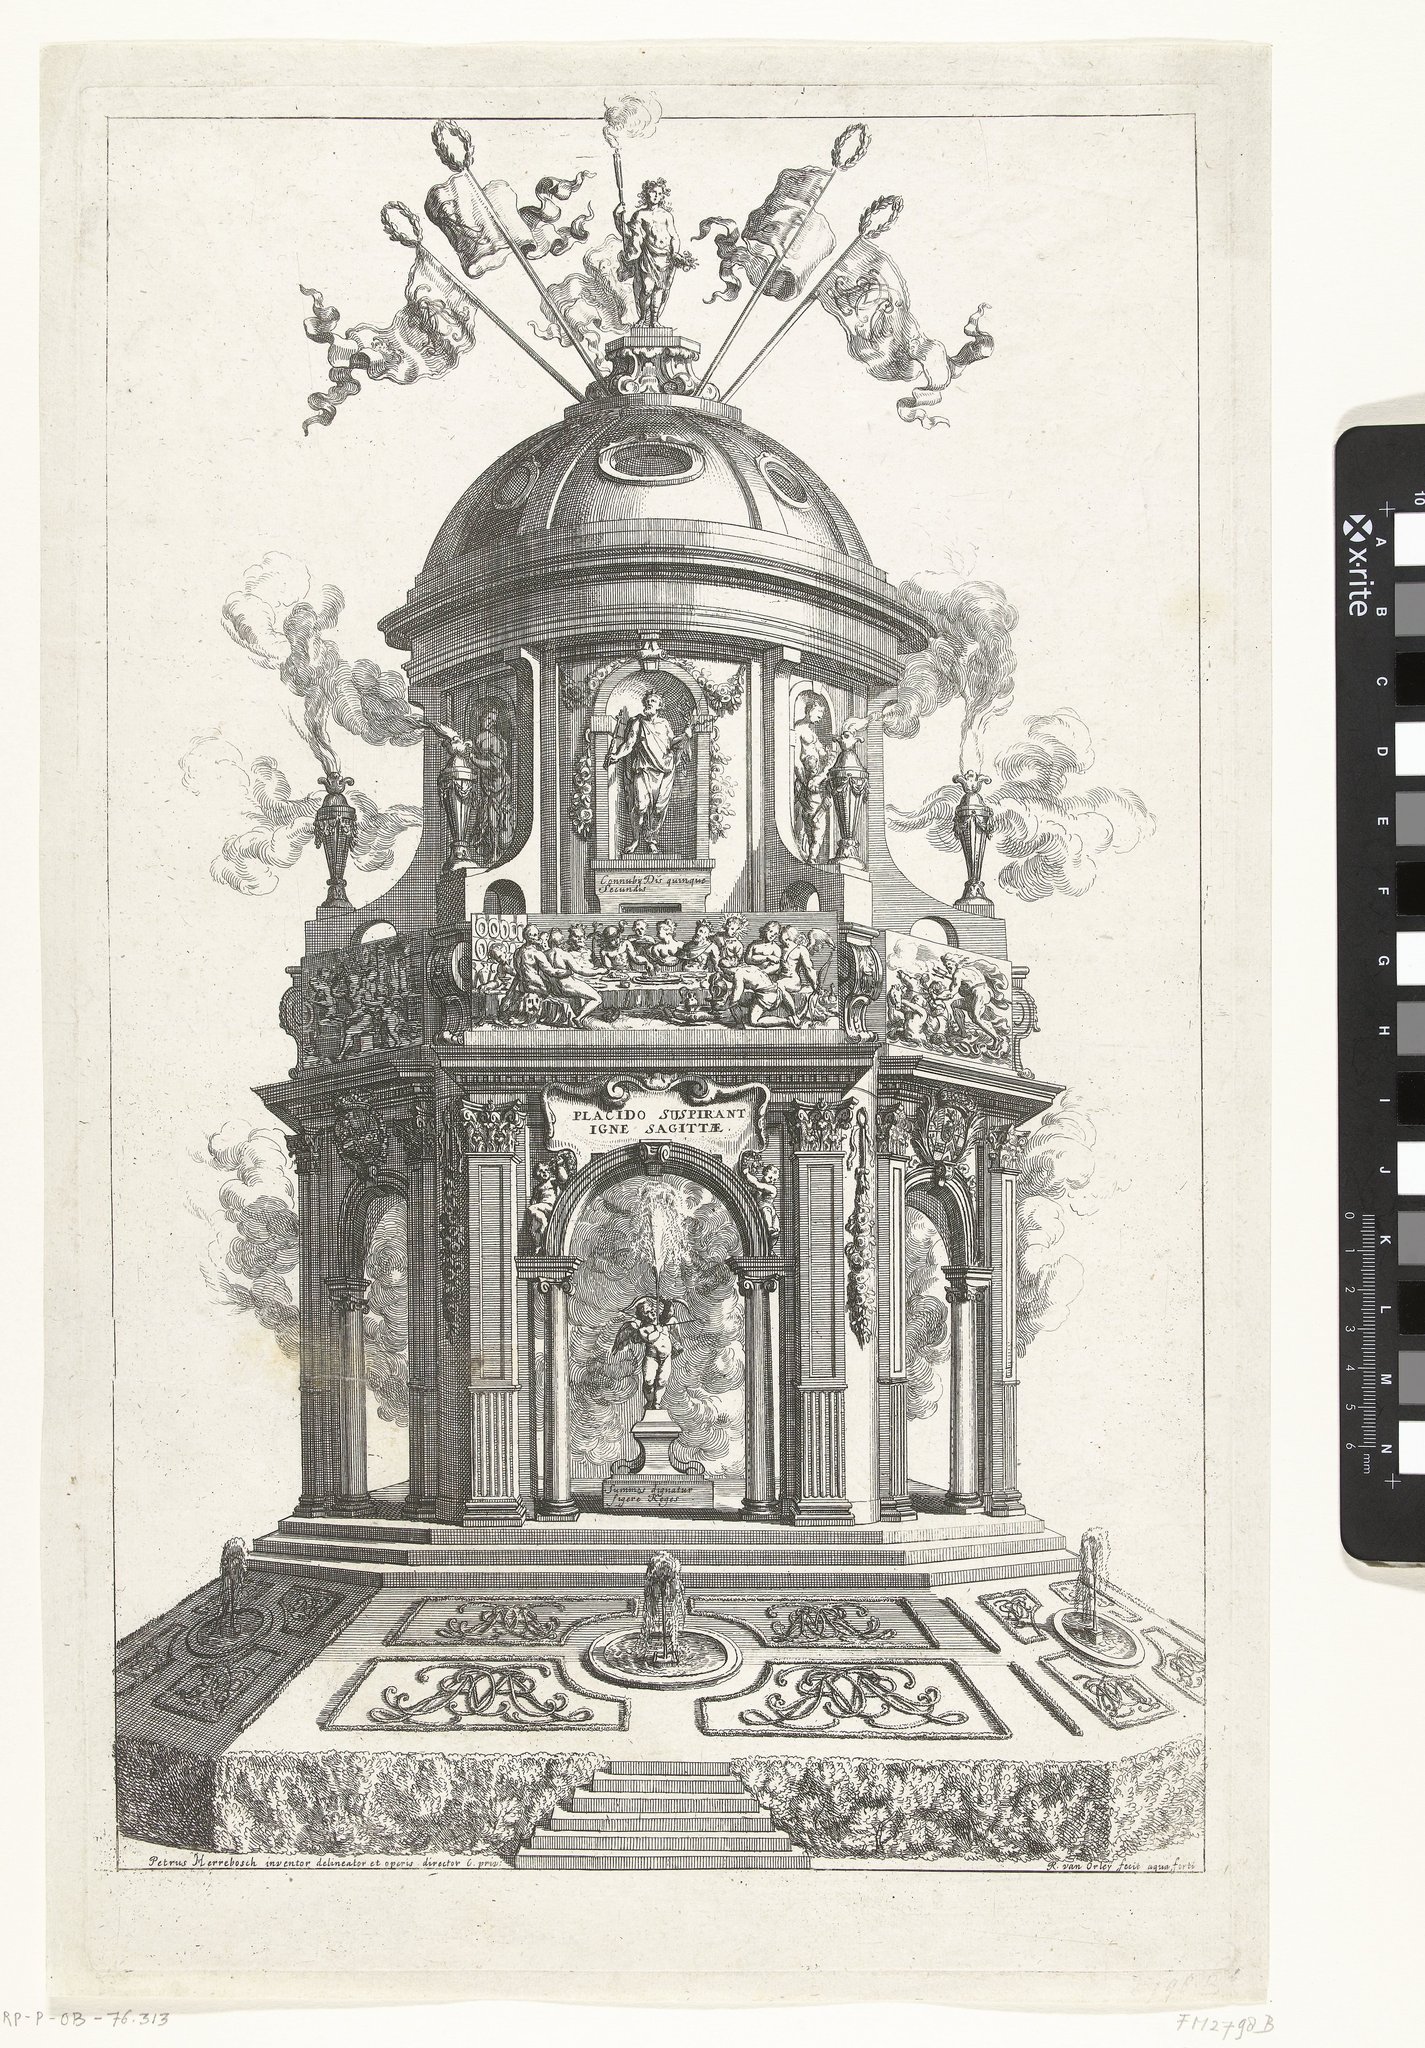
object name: print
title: Bouwwerk voor vuurwerk bij het huwelijk van Karel II van Spanje met Maria Anna van Beieren, 1690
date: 1690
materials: paper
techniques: etching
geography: southern netherlands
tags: karel ii (koning van spanje), public festivities at marriage of royal persons (+ illumination, fire-works ~ festive activities), other decorative structures (~ triumphal entry, etc.), brussels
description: Bouwwerk in de vorm van een tempietto voor het afsteken van vuurwerk opgesteld te Brussel bij het huwelijk van koning Karel II van Spanje met Maria Anna, prinses van Neuburg-Palts op 14 mei 1690. Versierd met allegorische en mythologische voorstellingen.